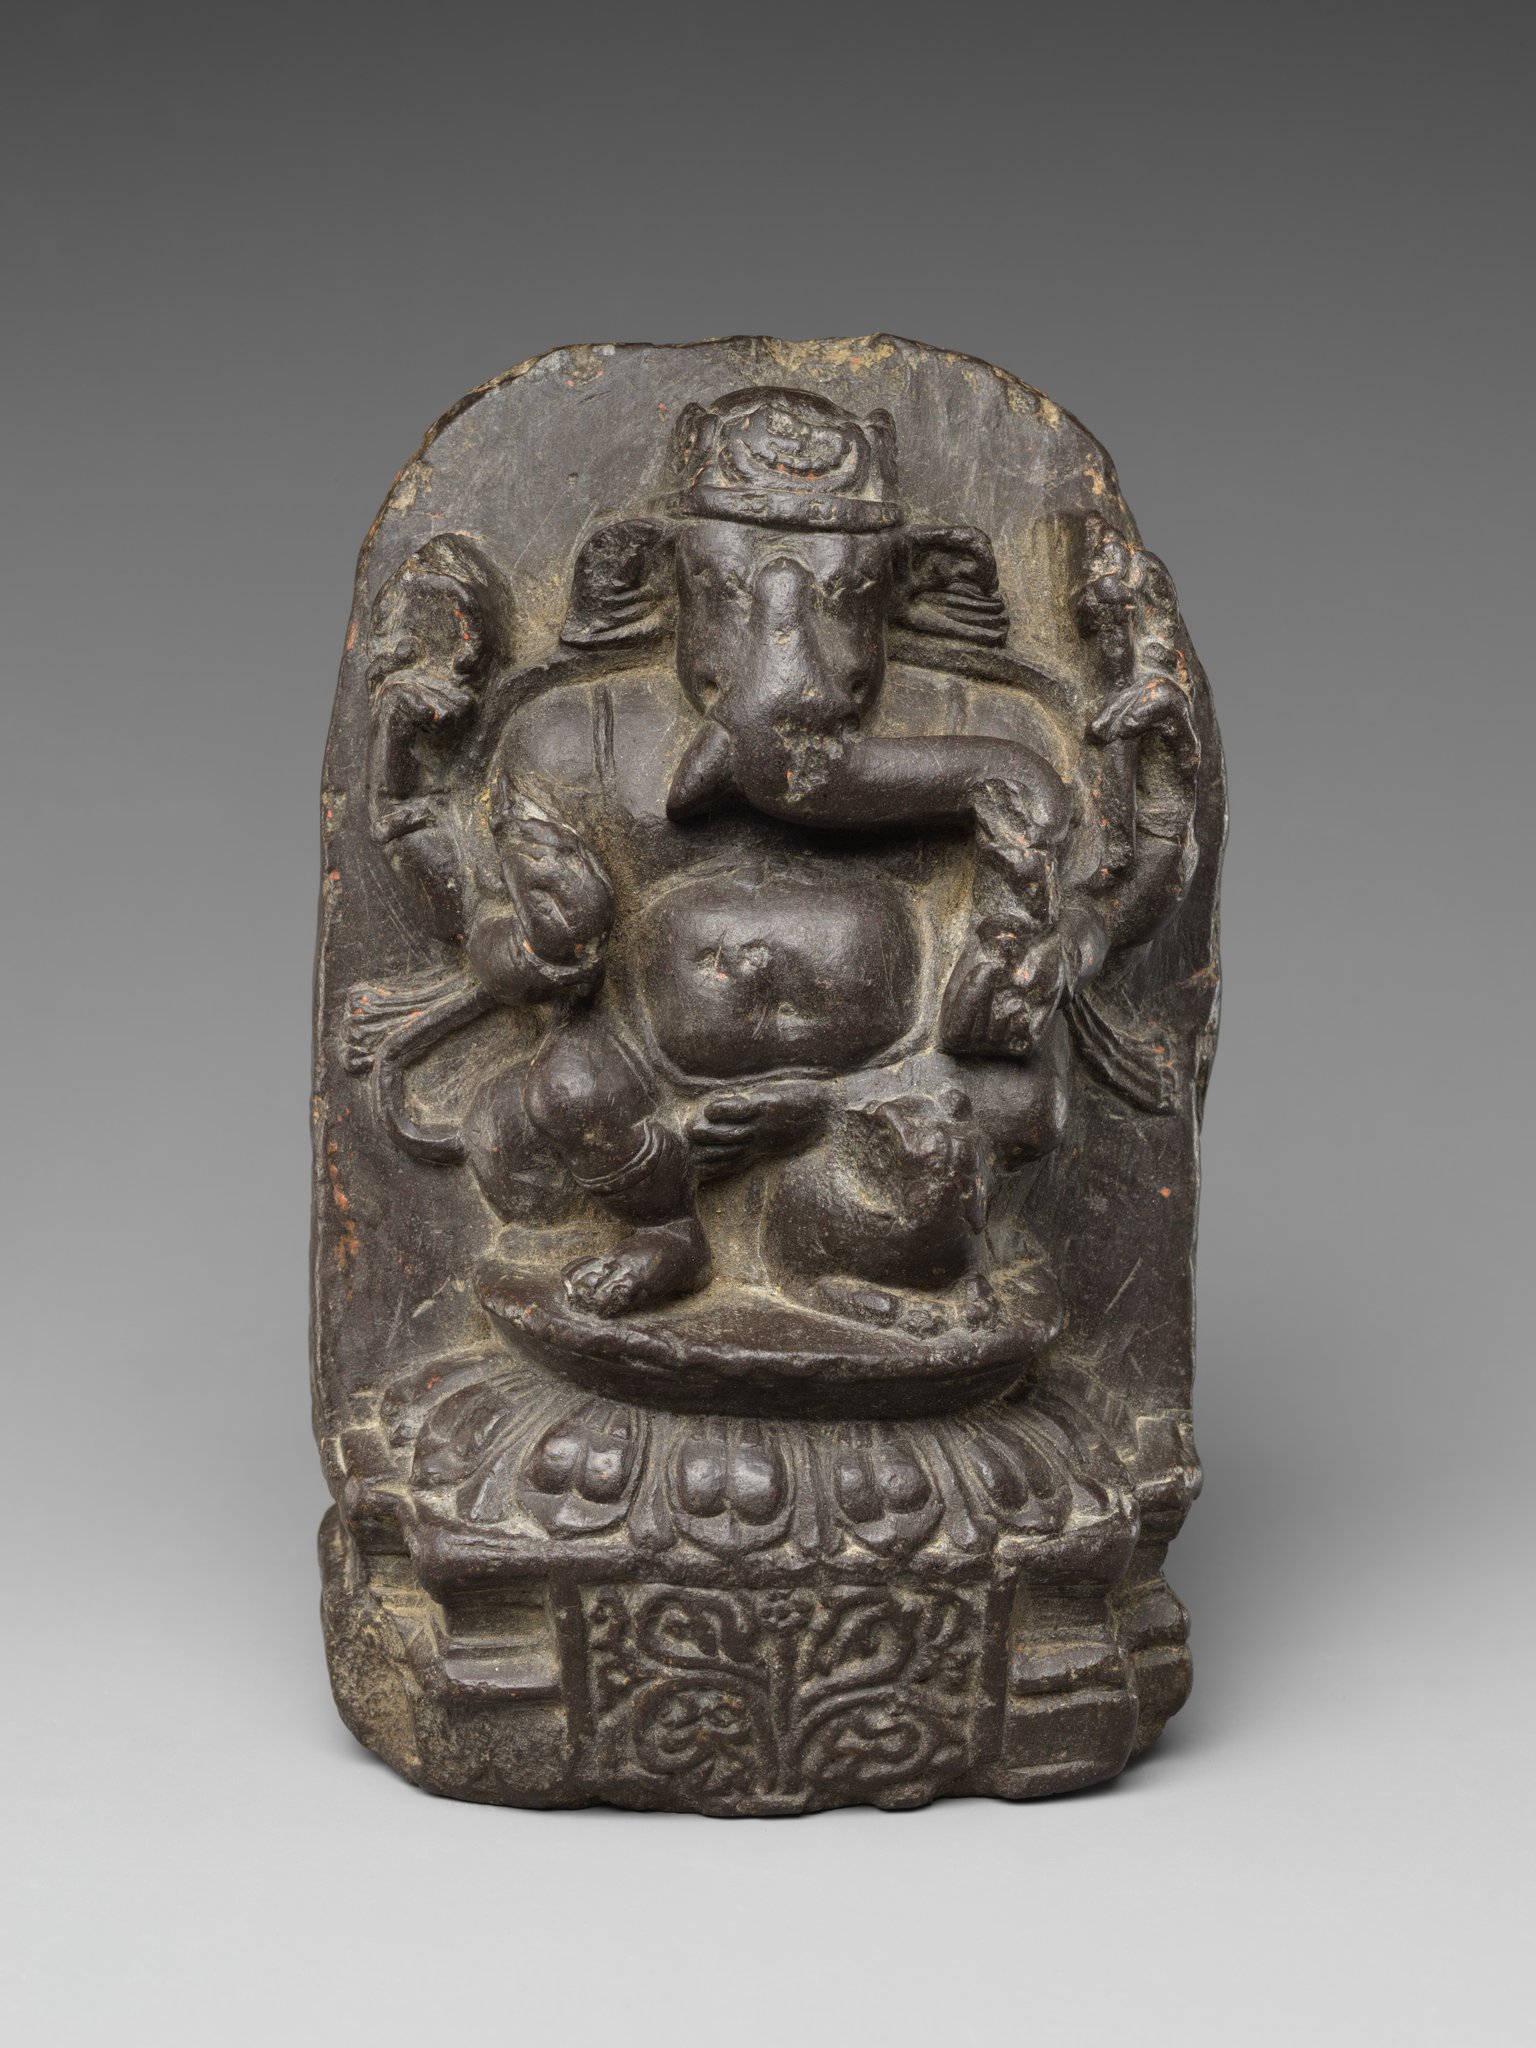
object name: figure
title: Seated Ganesha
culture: indian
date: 834-866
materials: stone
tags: kashmir